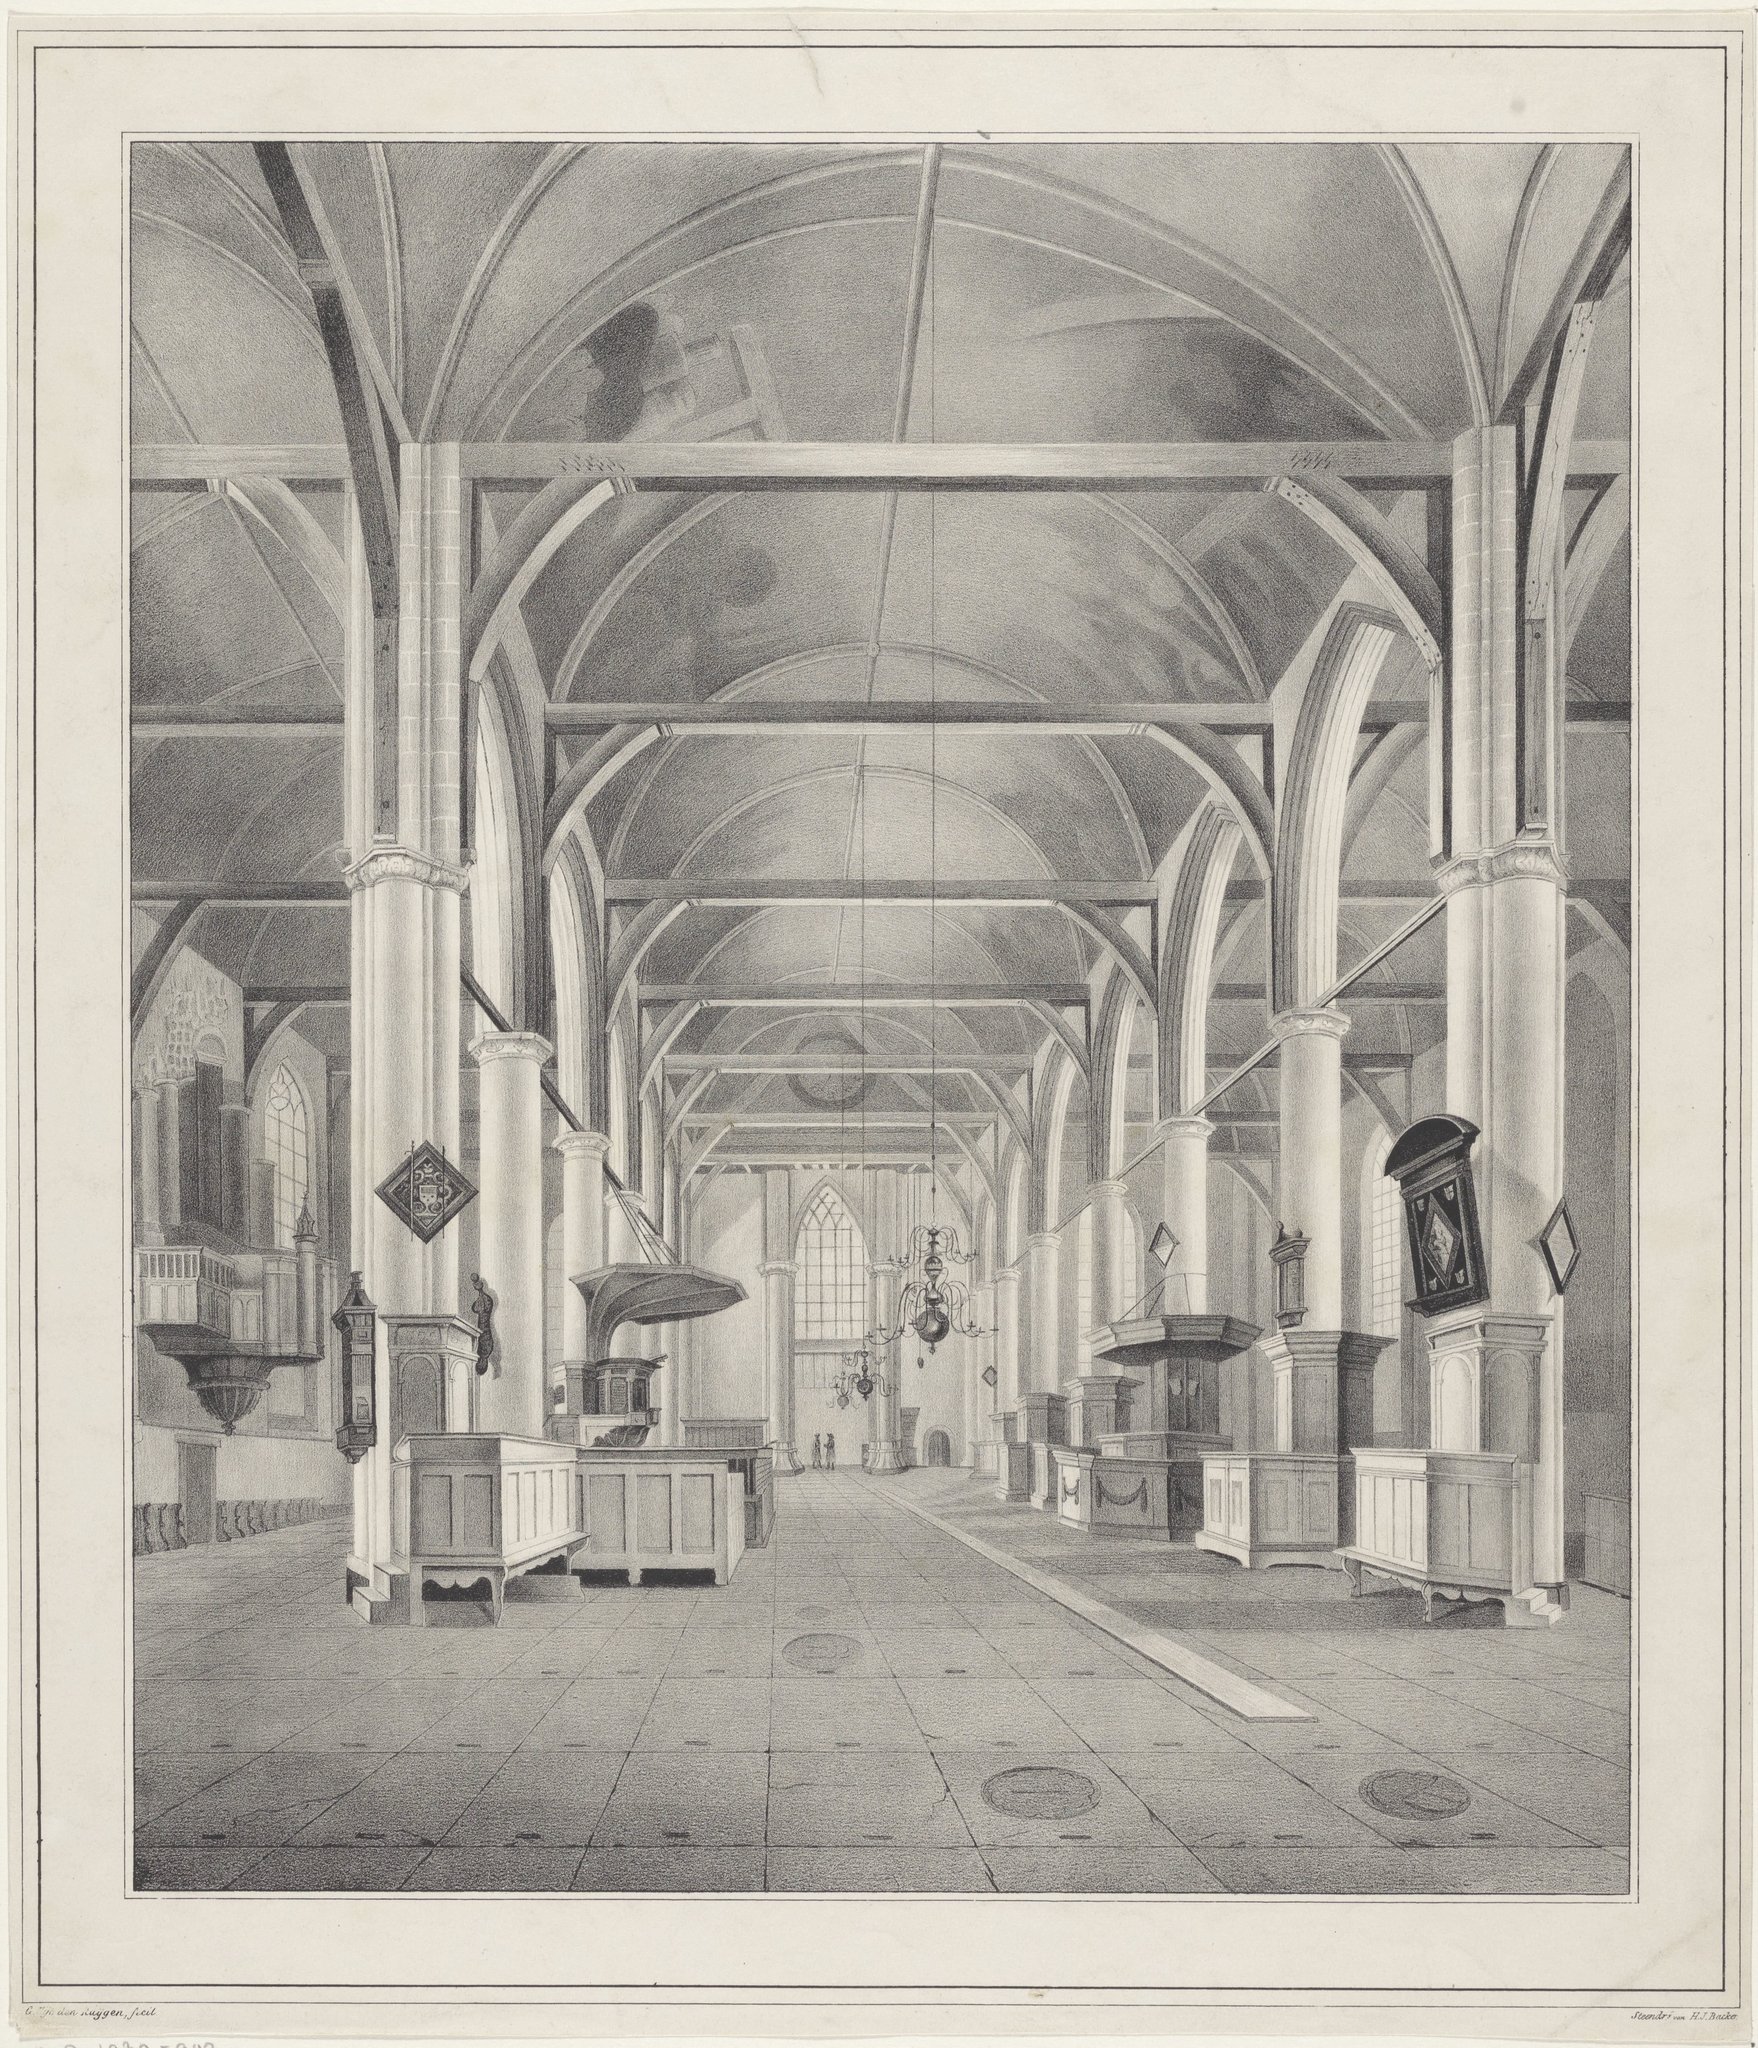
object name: print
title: Kerkinterieur van de Grote Kerk in Hoorn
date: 1822-1845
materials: paper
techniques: lithograph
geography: hoorn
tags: interior of church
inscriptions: collector's mark: Lugt 2760, collector's mark: Lugt 2228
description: Interieur van het schip van de kerk. In het midden houten balken en tongewelven. Op het plafond zijn schilderingen aangebracht. Achter in de kerk staan twee figuren.